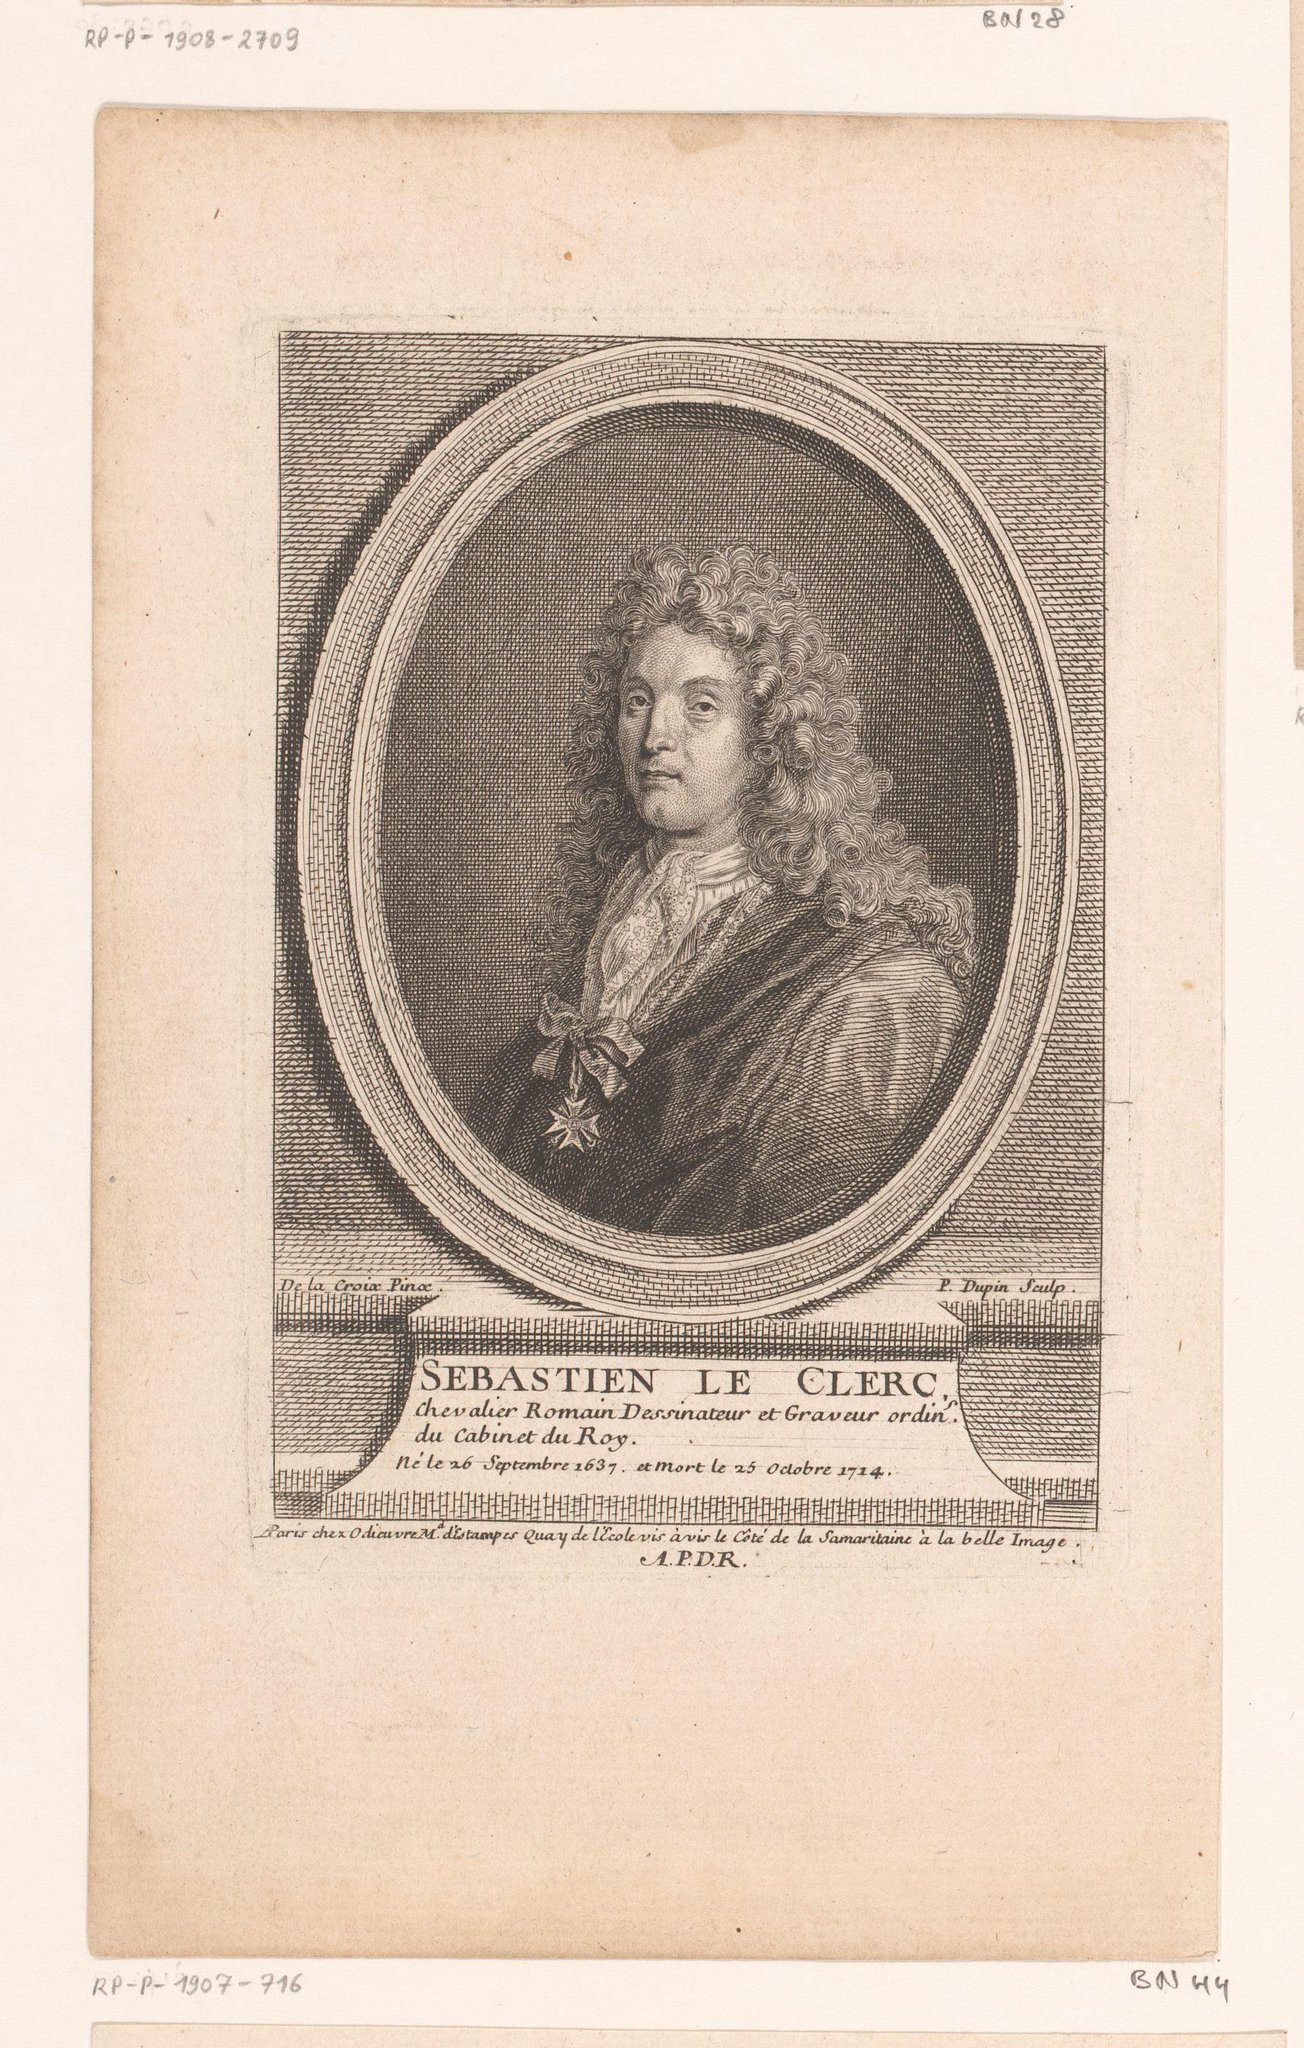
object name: print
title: Portret van Sébastien Leclerc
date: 1700-1751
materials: paper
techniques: engraving, etching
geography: paris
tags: print maker, sébastien leclerc (i), ornament ~ medallion, portrait, self-portrait of graphic artist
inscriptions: collector's mark: Lugt 2228